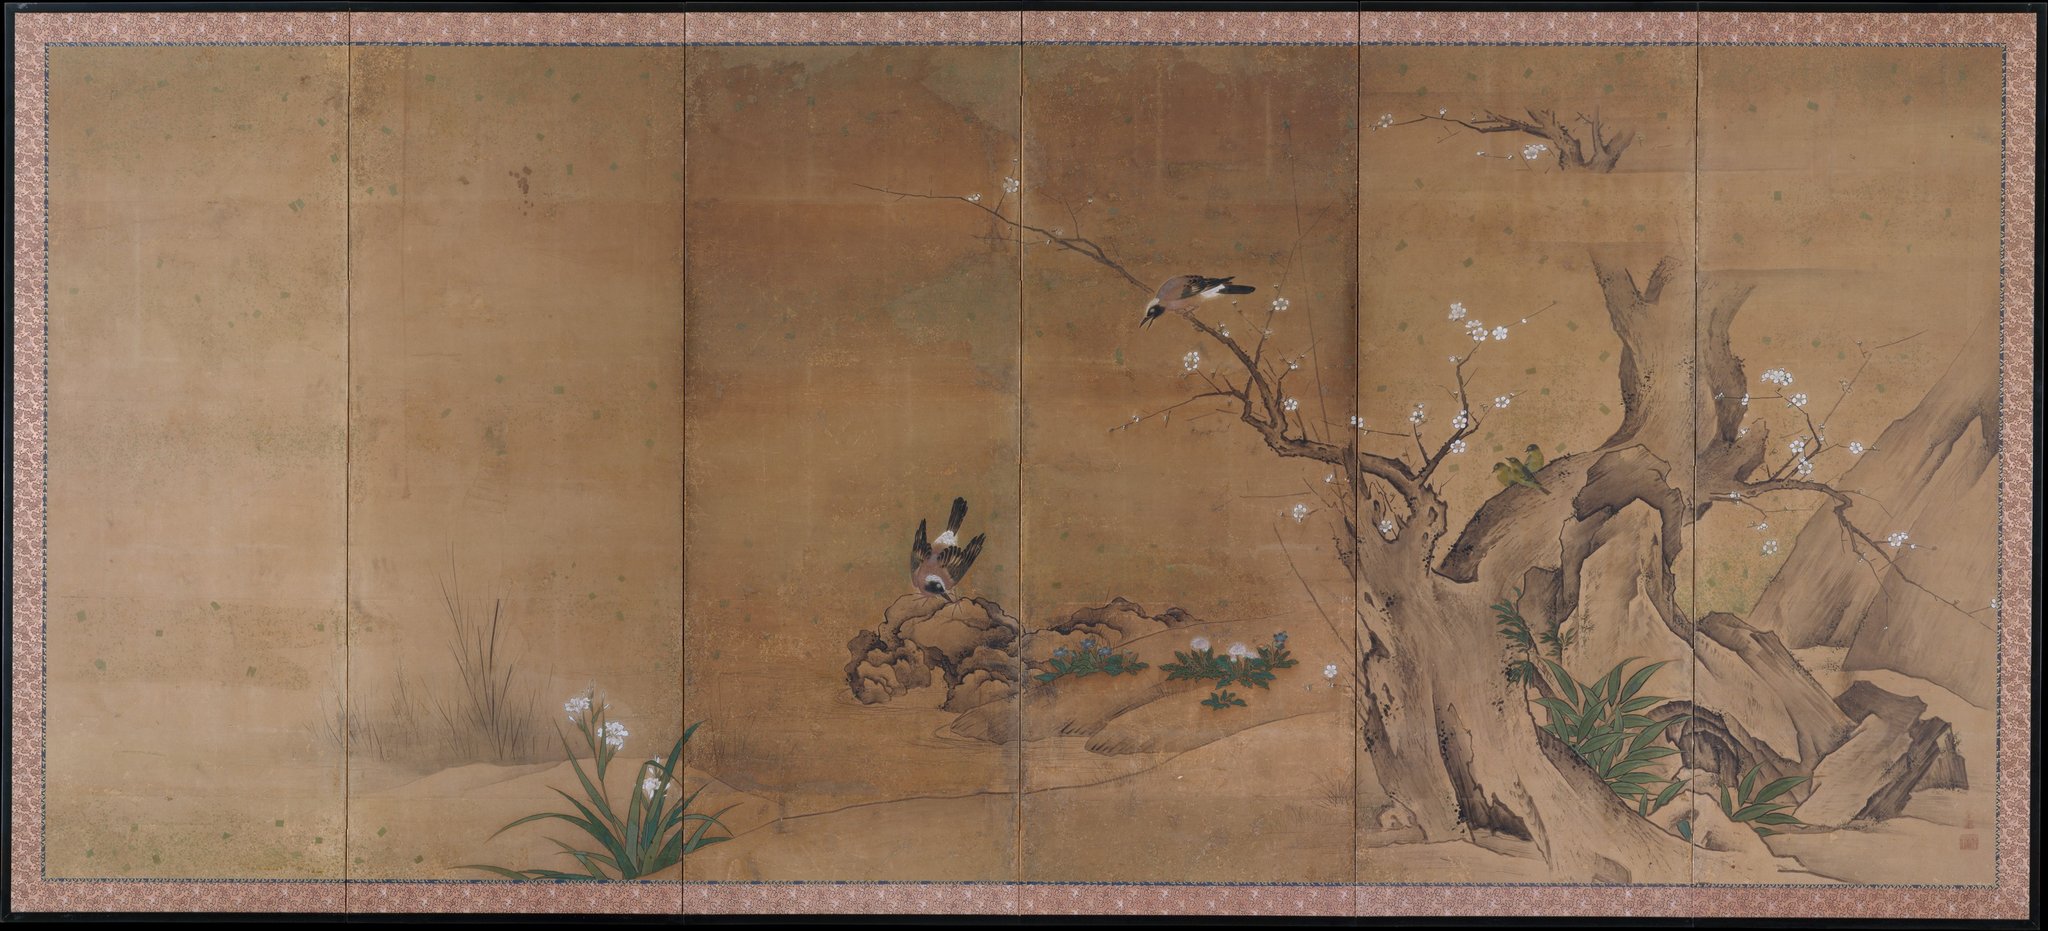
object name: screen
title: Birds and Flowers of the Four Seasons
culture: japanese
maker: kano sanboku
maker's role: artist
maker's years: 1671-1725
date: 1667-1700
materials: gold, ink, panel, paper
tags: birds,flowers,bamboo